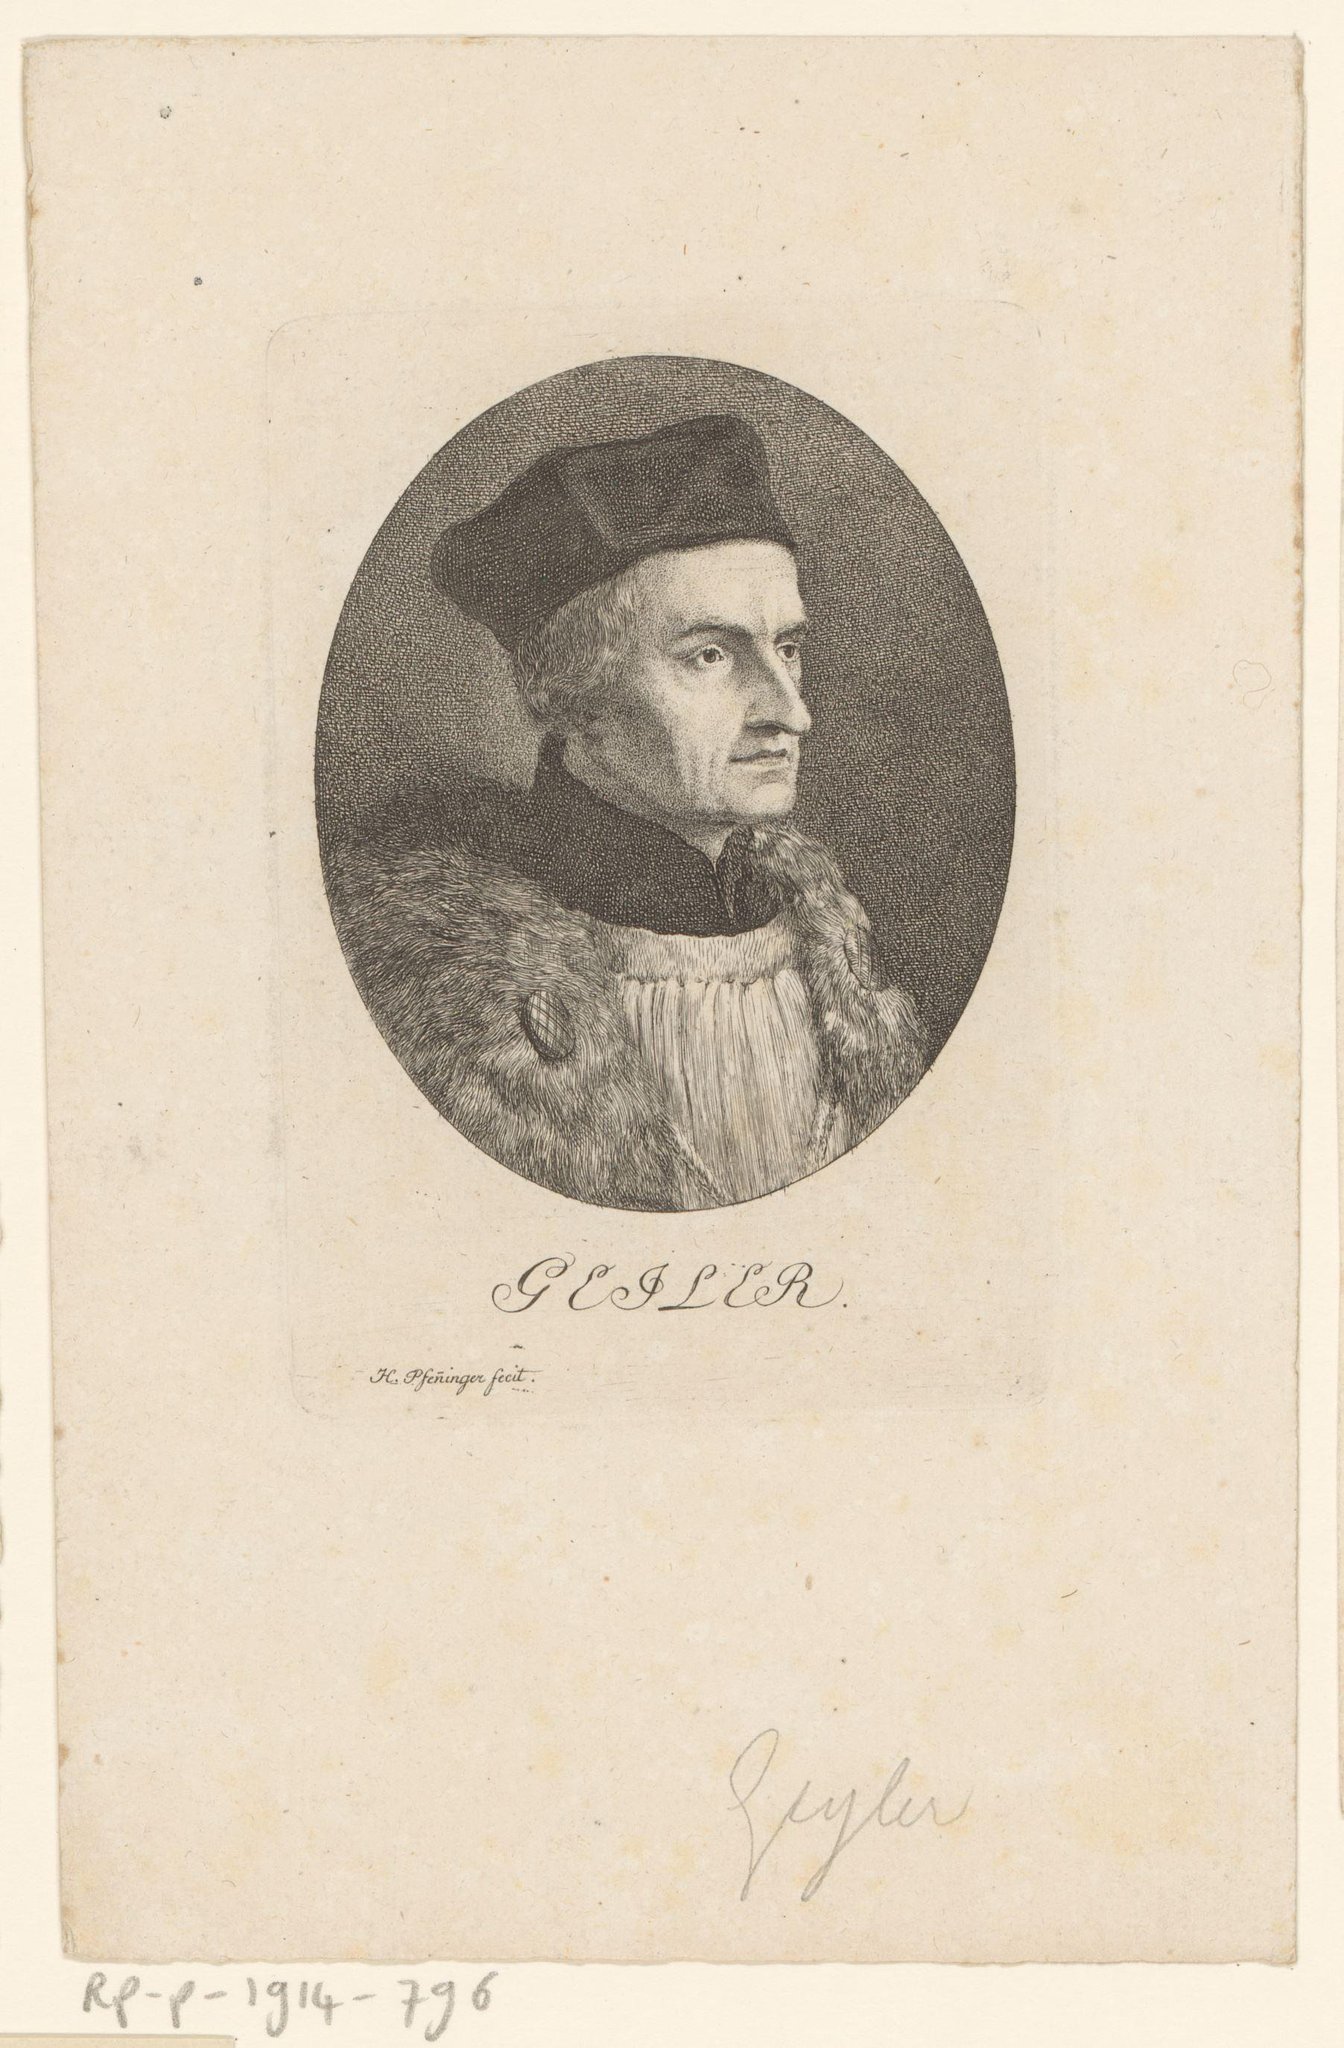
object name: print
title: Portret van Johannes Geiler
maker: heinrich pfenninger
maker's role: print maker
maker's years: 1749-1815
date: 1759-1815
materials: paper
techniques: etching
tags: historical persons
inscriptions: collector's mark: Lugt 2228